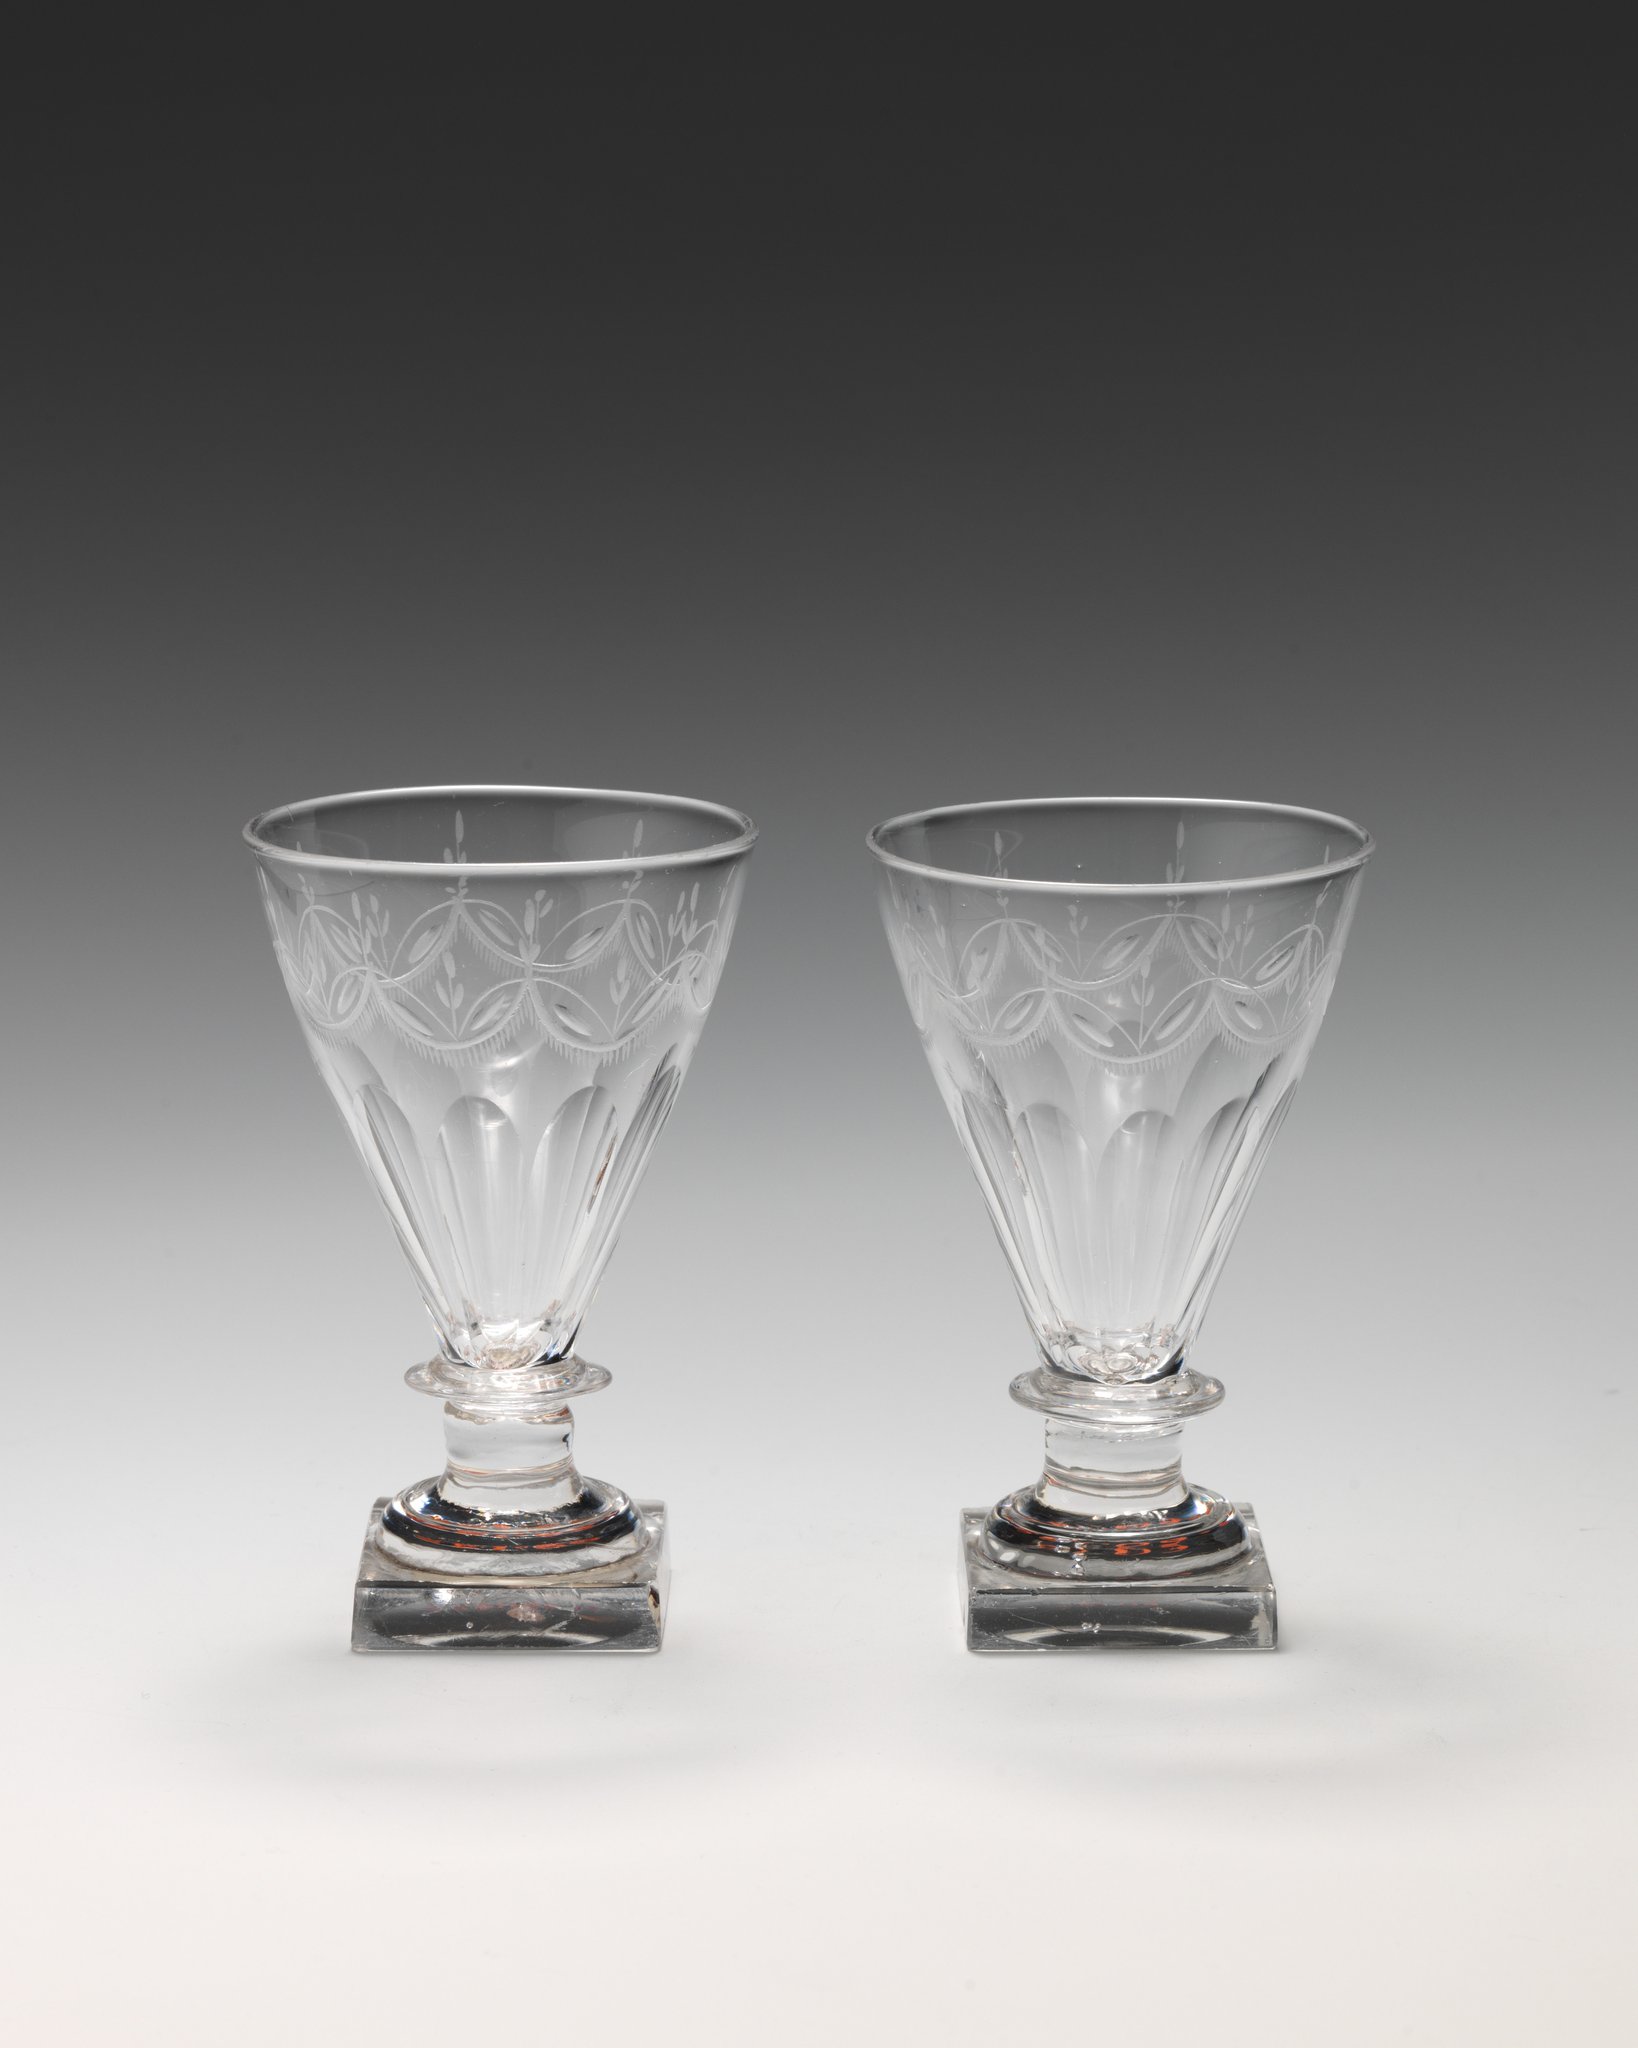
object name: wineglass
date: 1701-1800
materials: glass